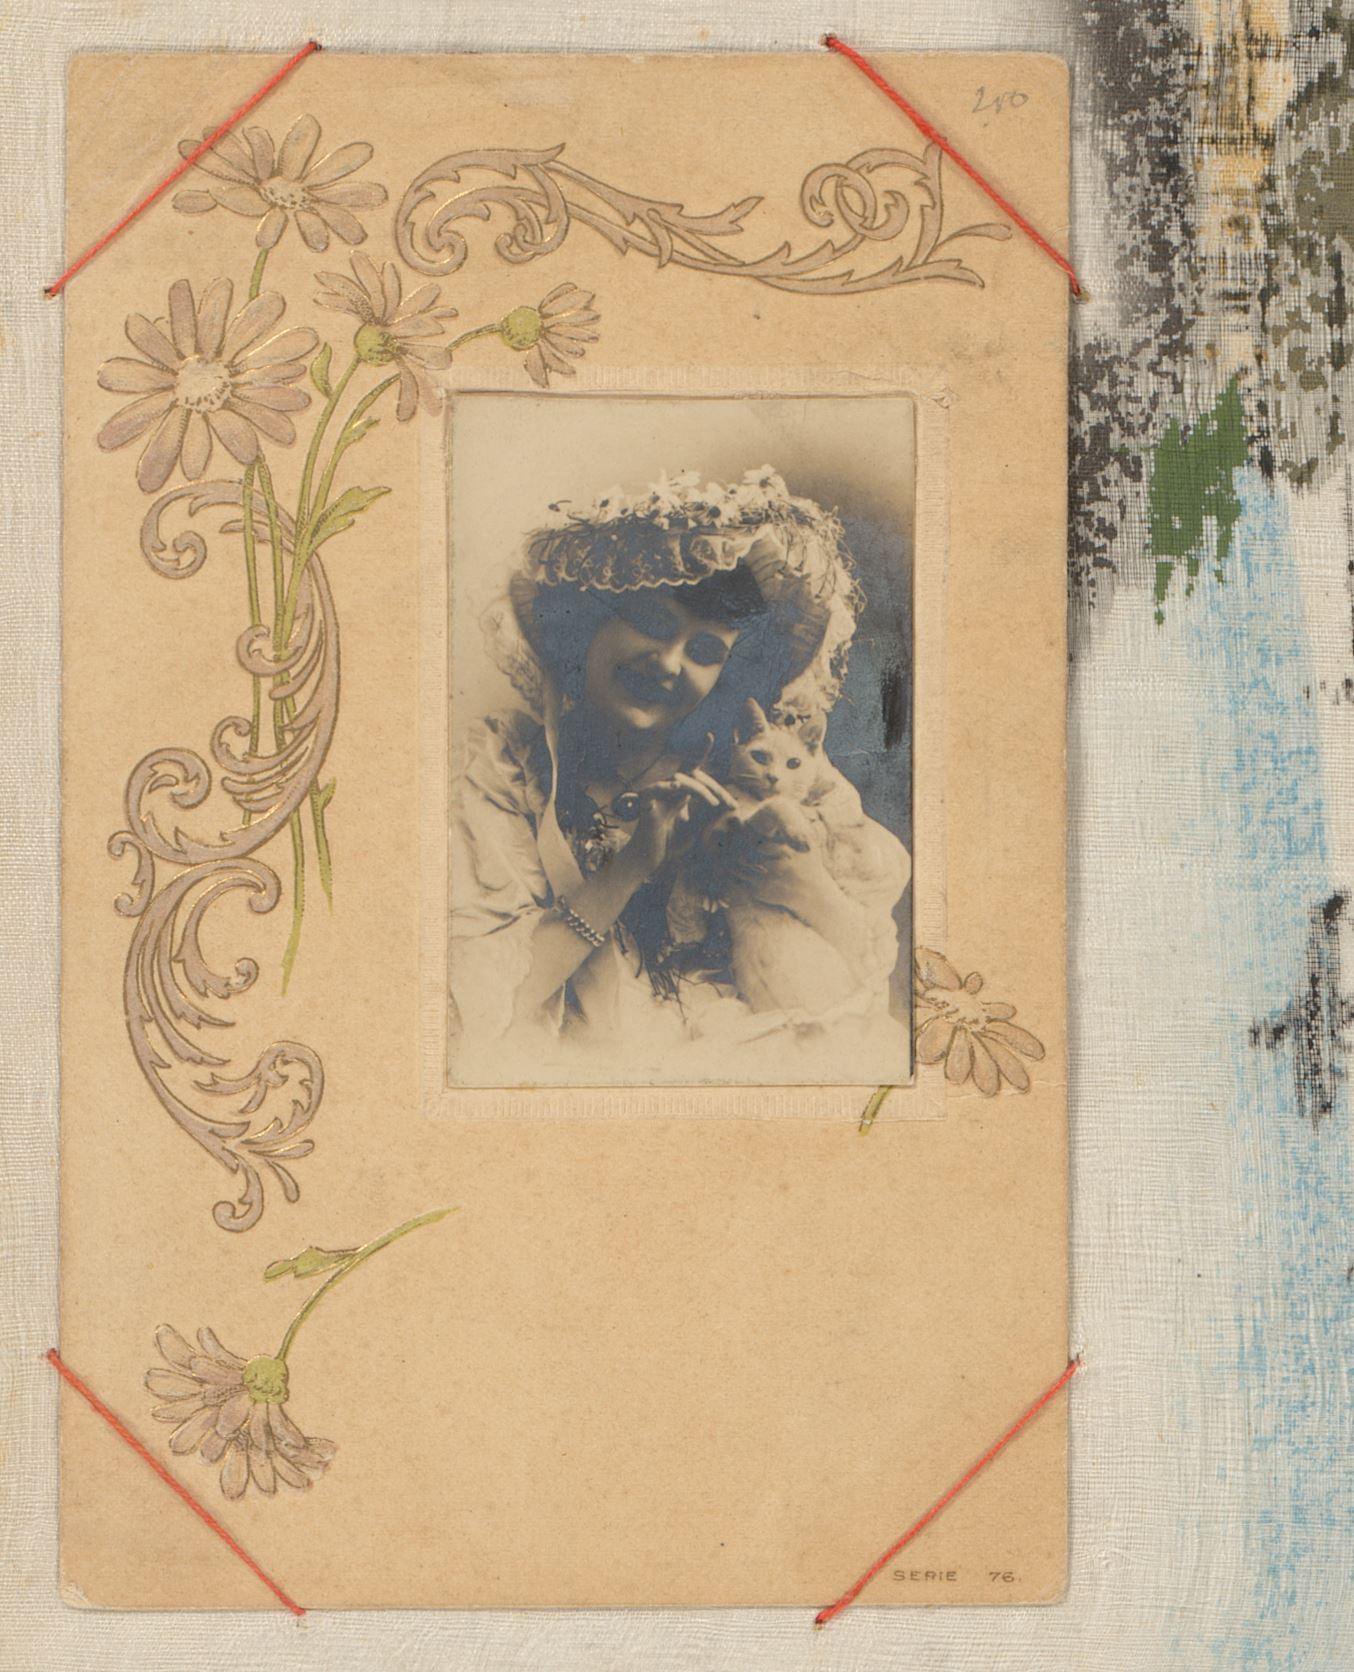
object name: ansichtkaart, prentbriefkaart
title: Portret van een vrouw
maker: Anonymous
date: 1880-1910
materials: cardboard, paint, photographic support, silk, textile, watercolor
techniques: blind stamped, brush, gelatin silver print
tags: adult woman, historical persons